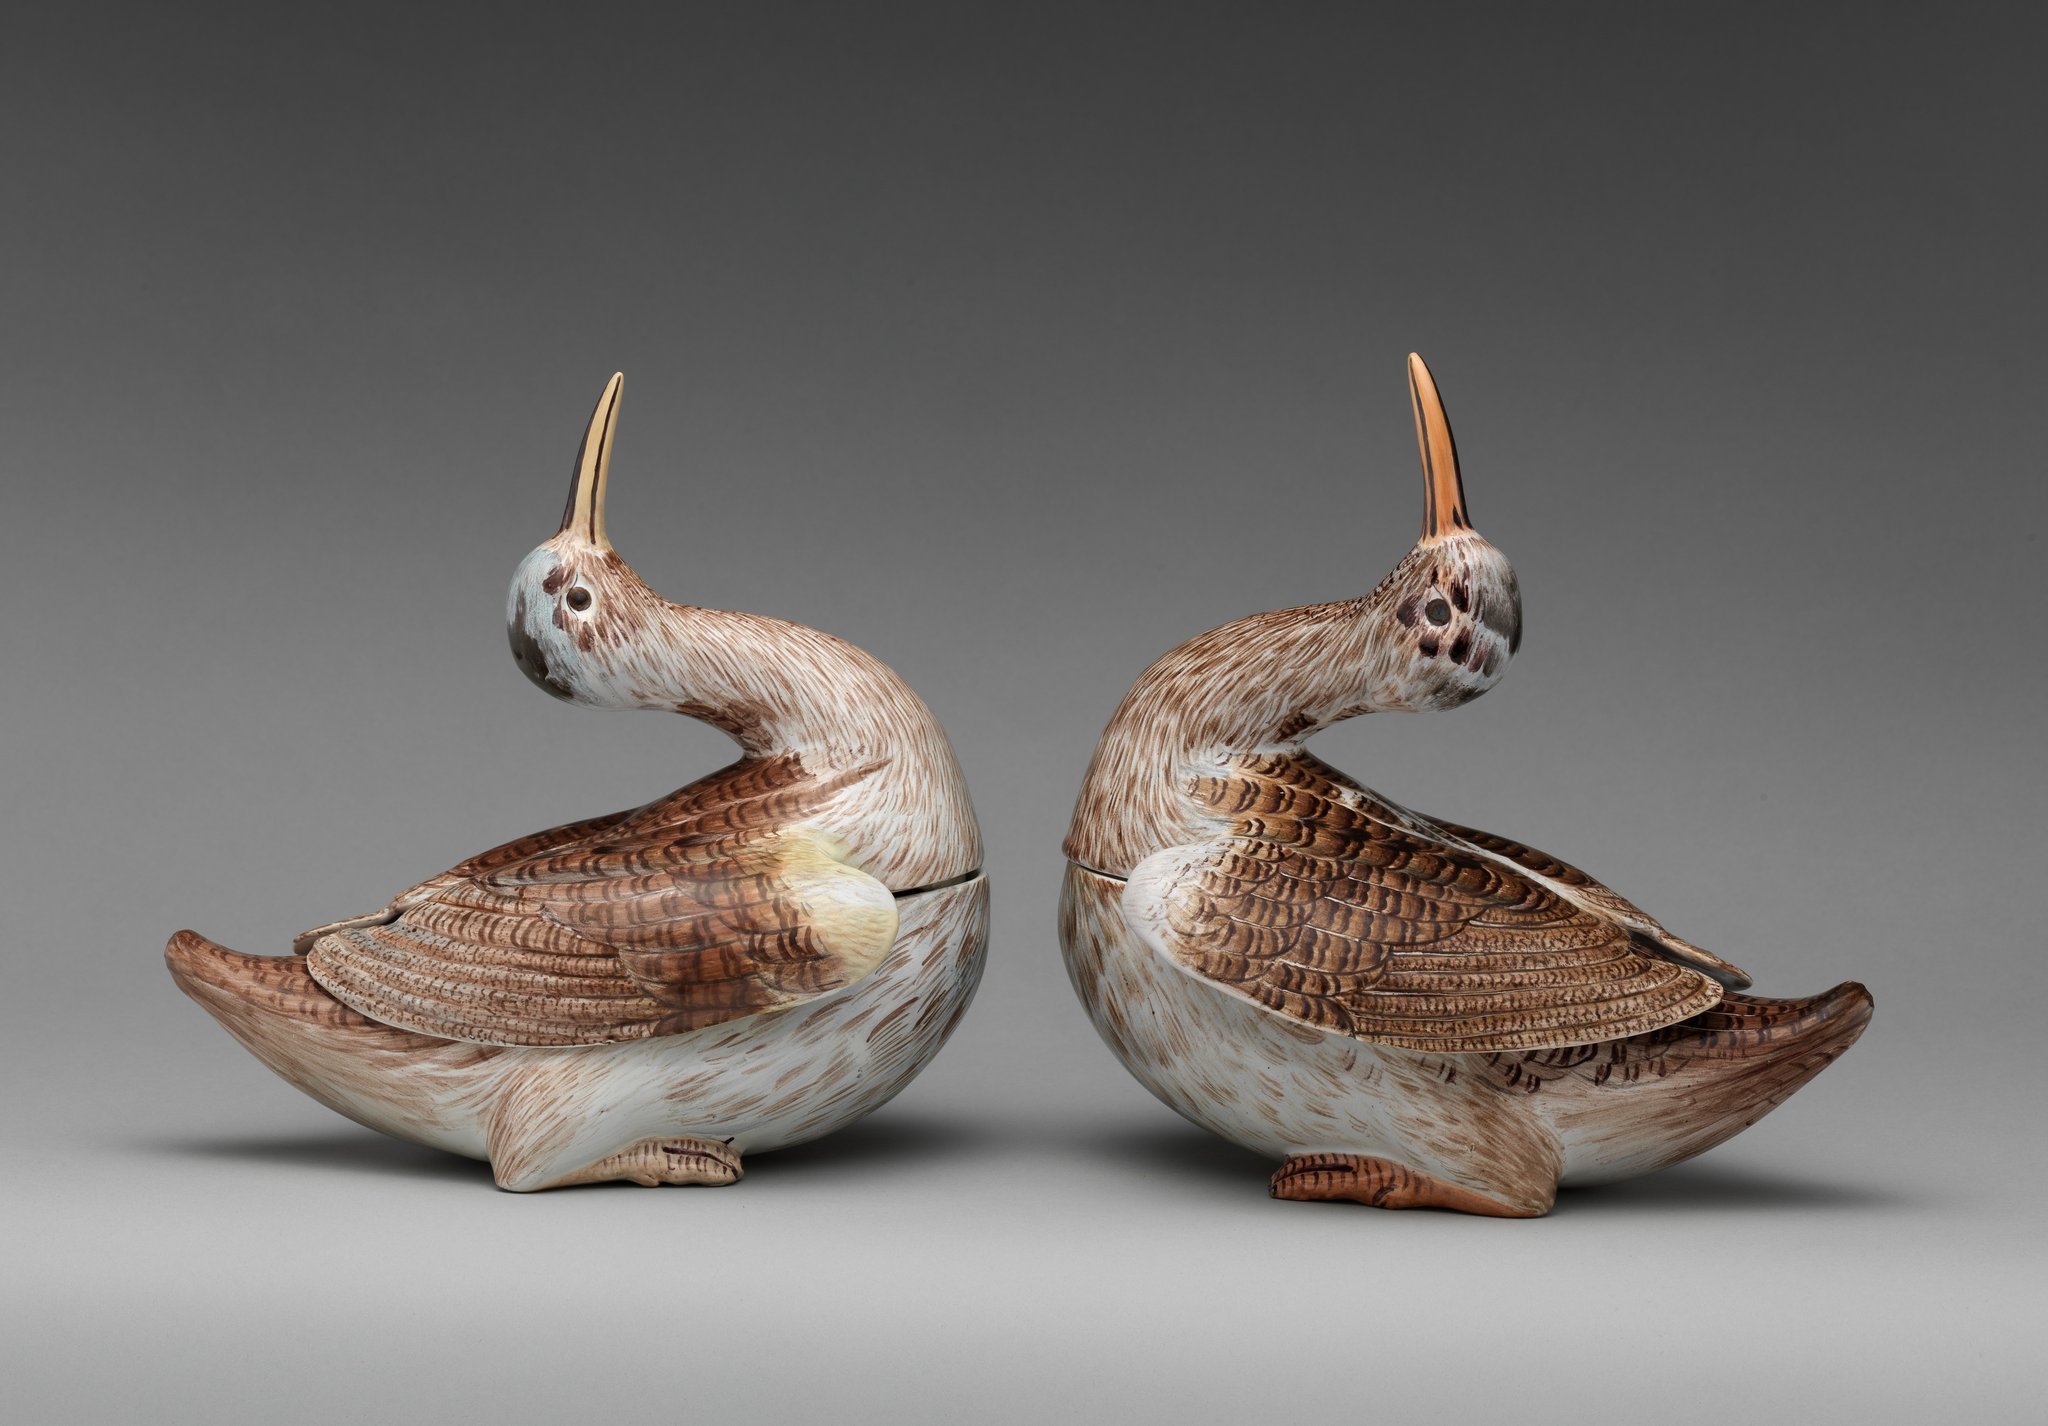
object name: tureen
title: Tureen in the form of a woodcock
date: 1750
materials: earthenware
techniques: glazing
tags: birds